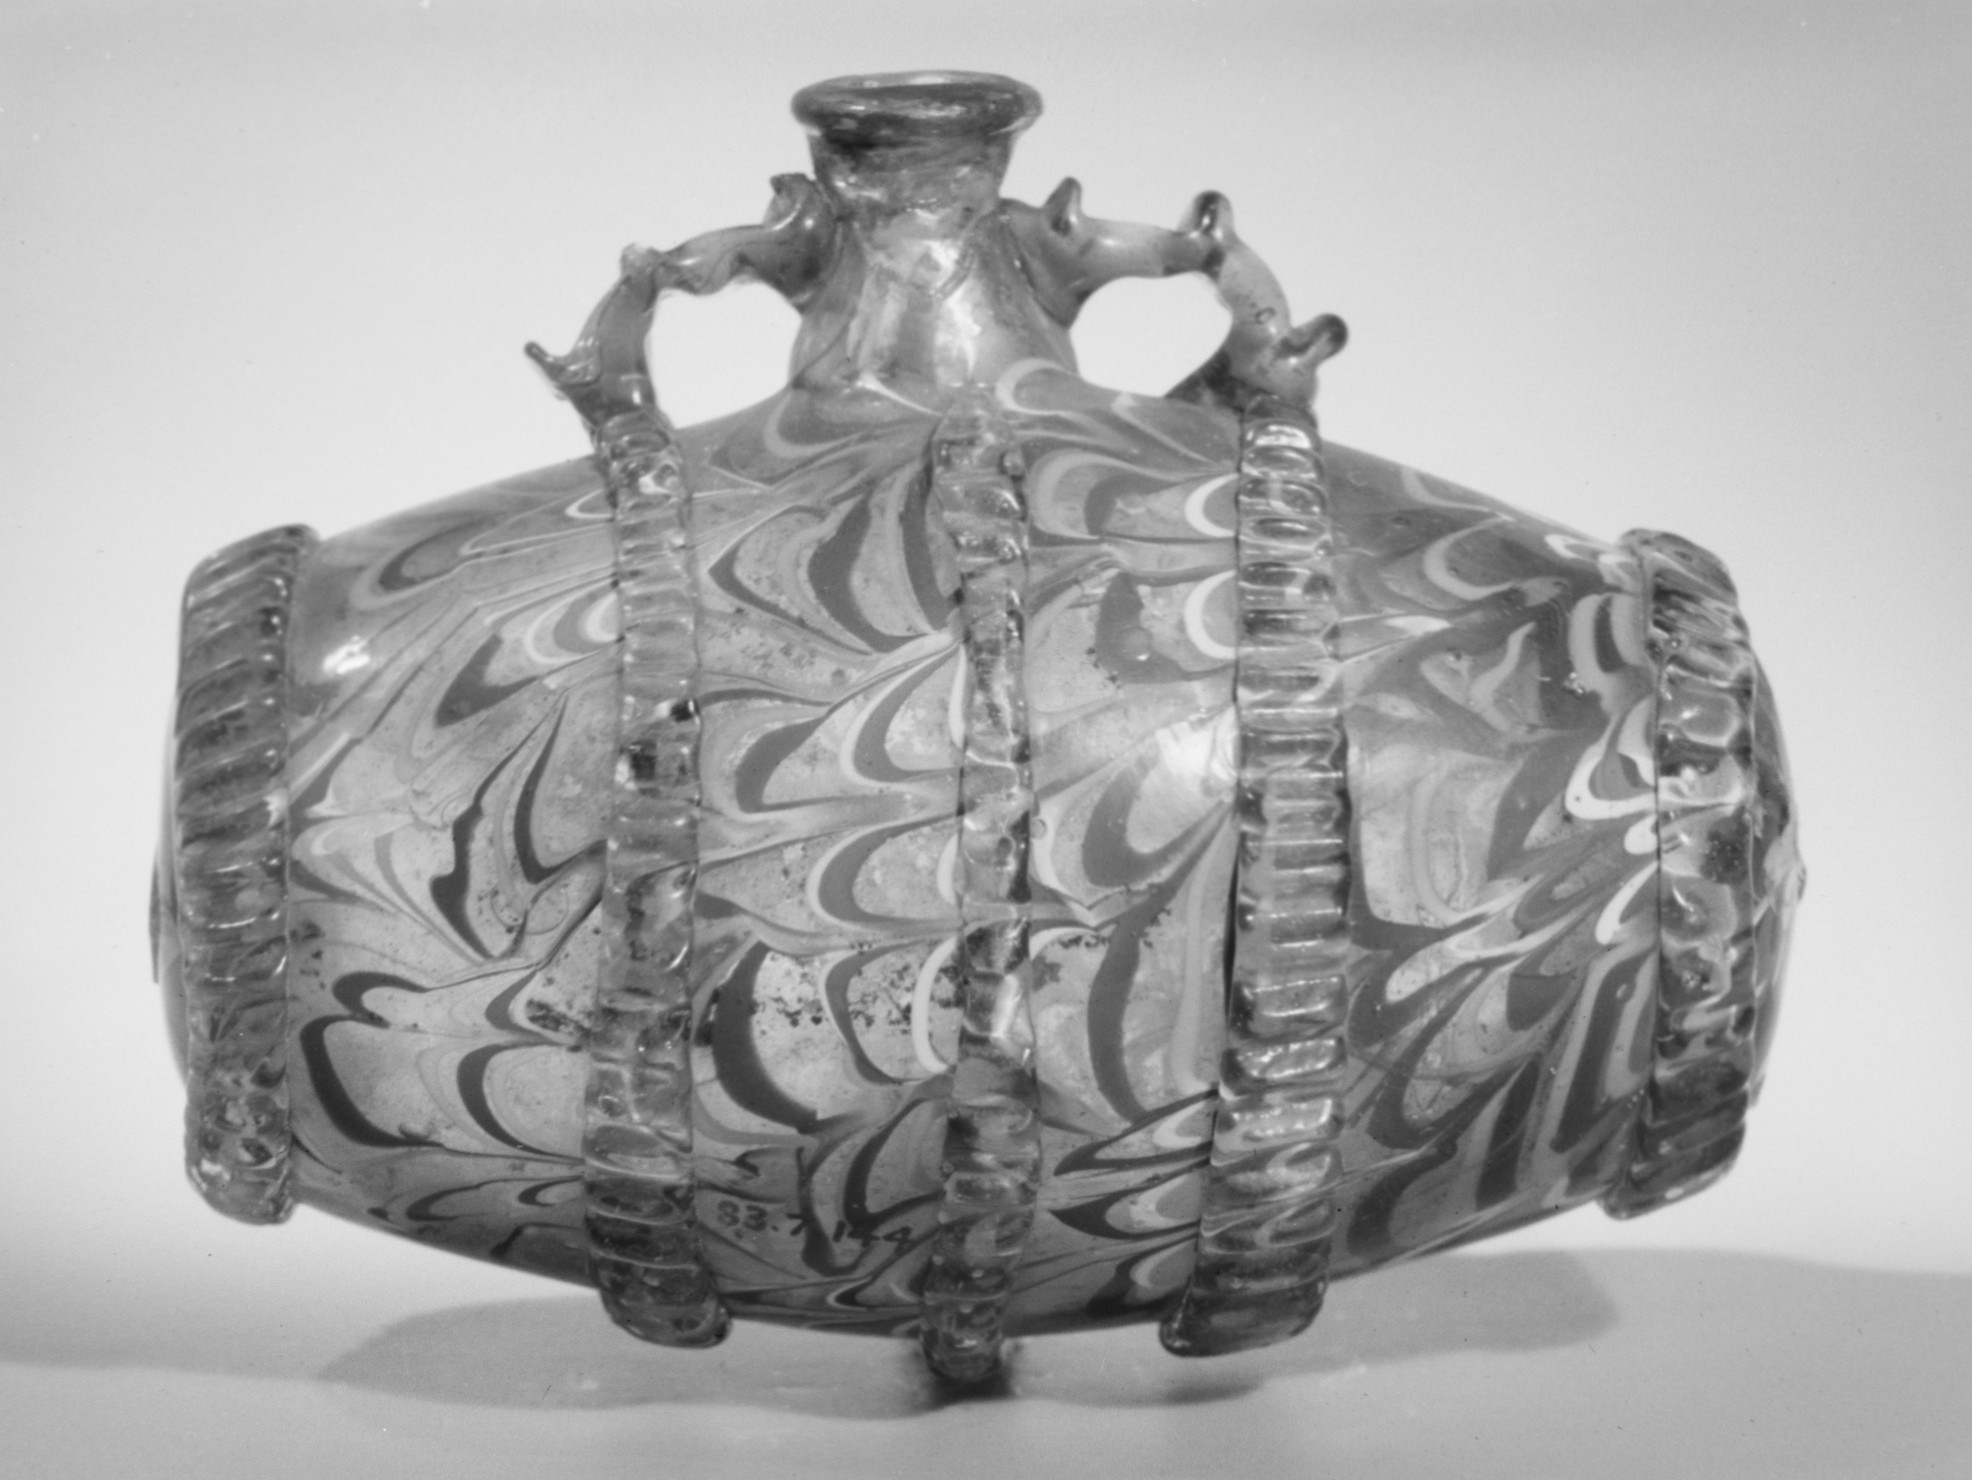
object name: flask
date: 1601-1800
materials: glass